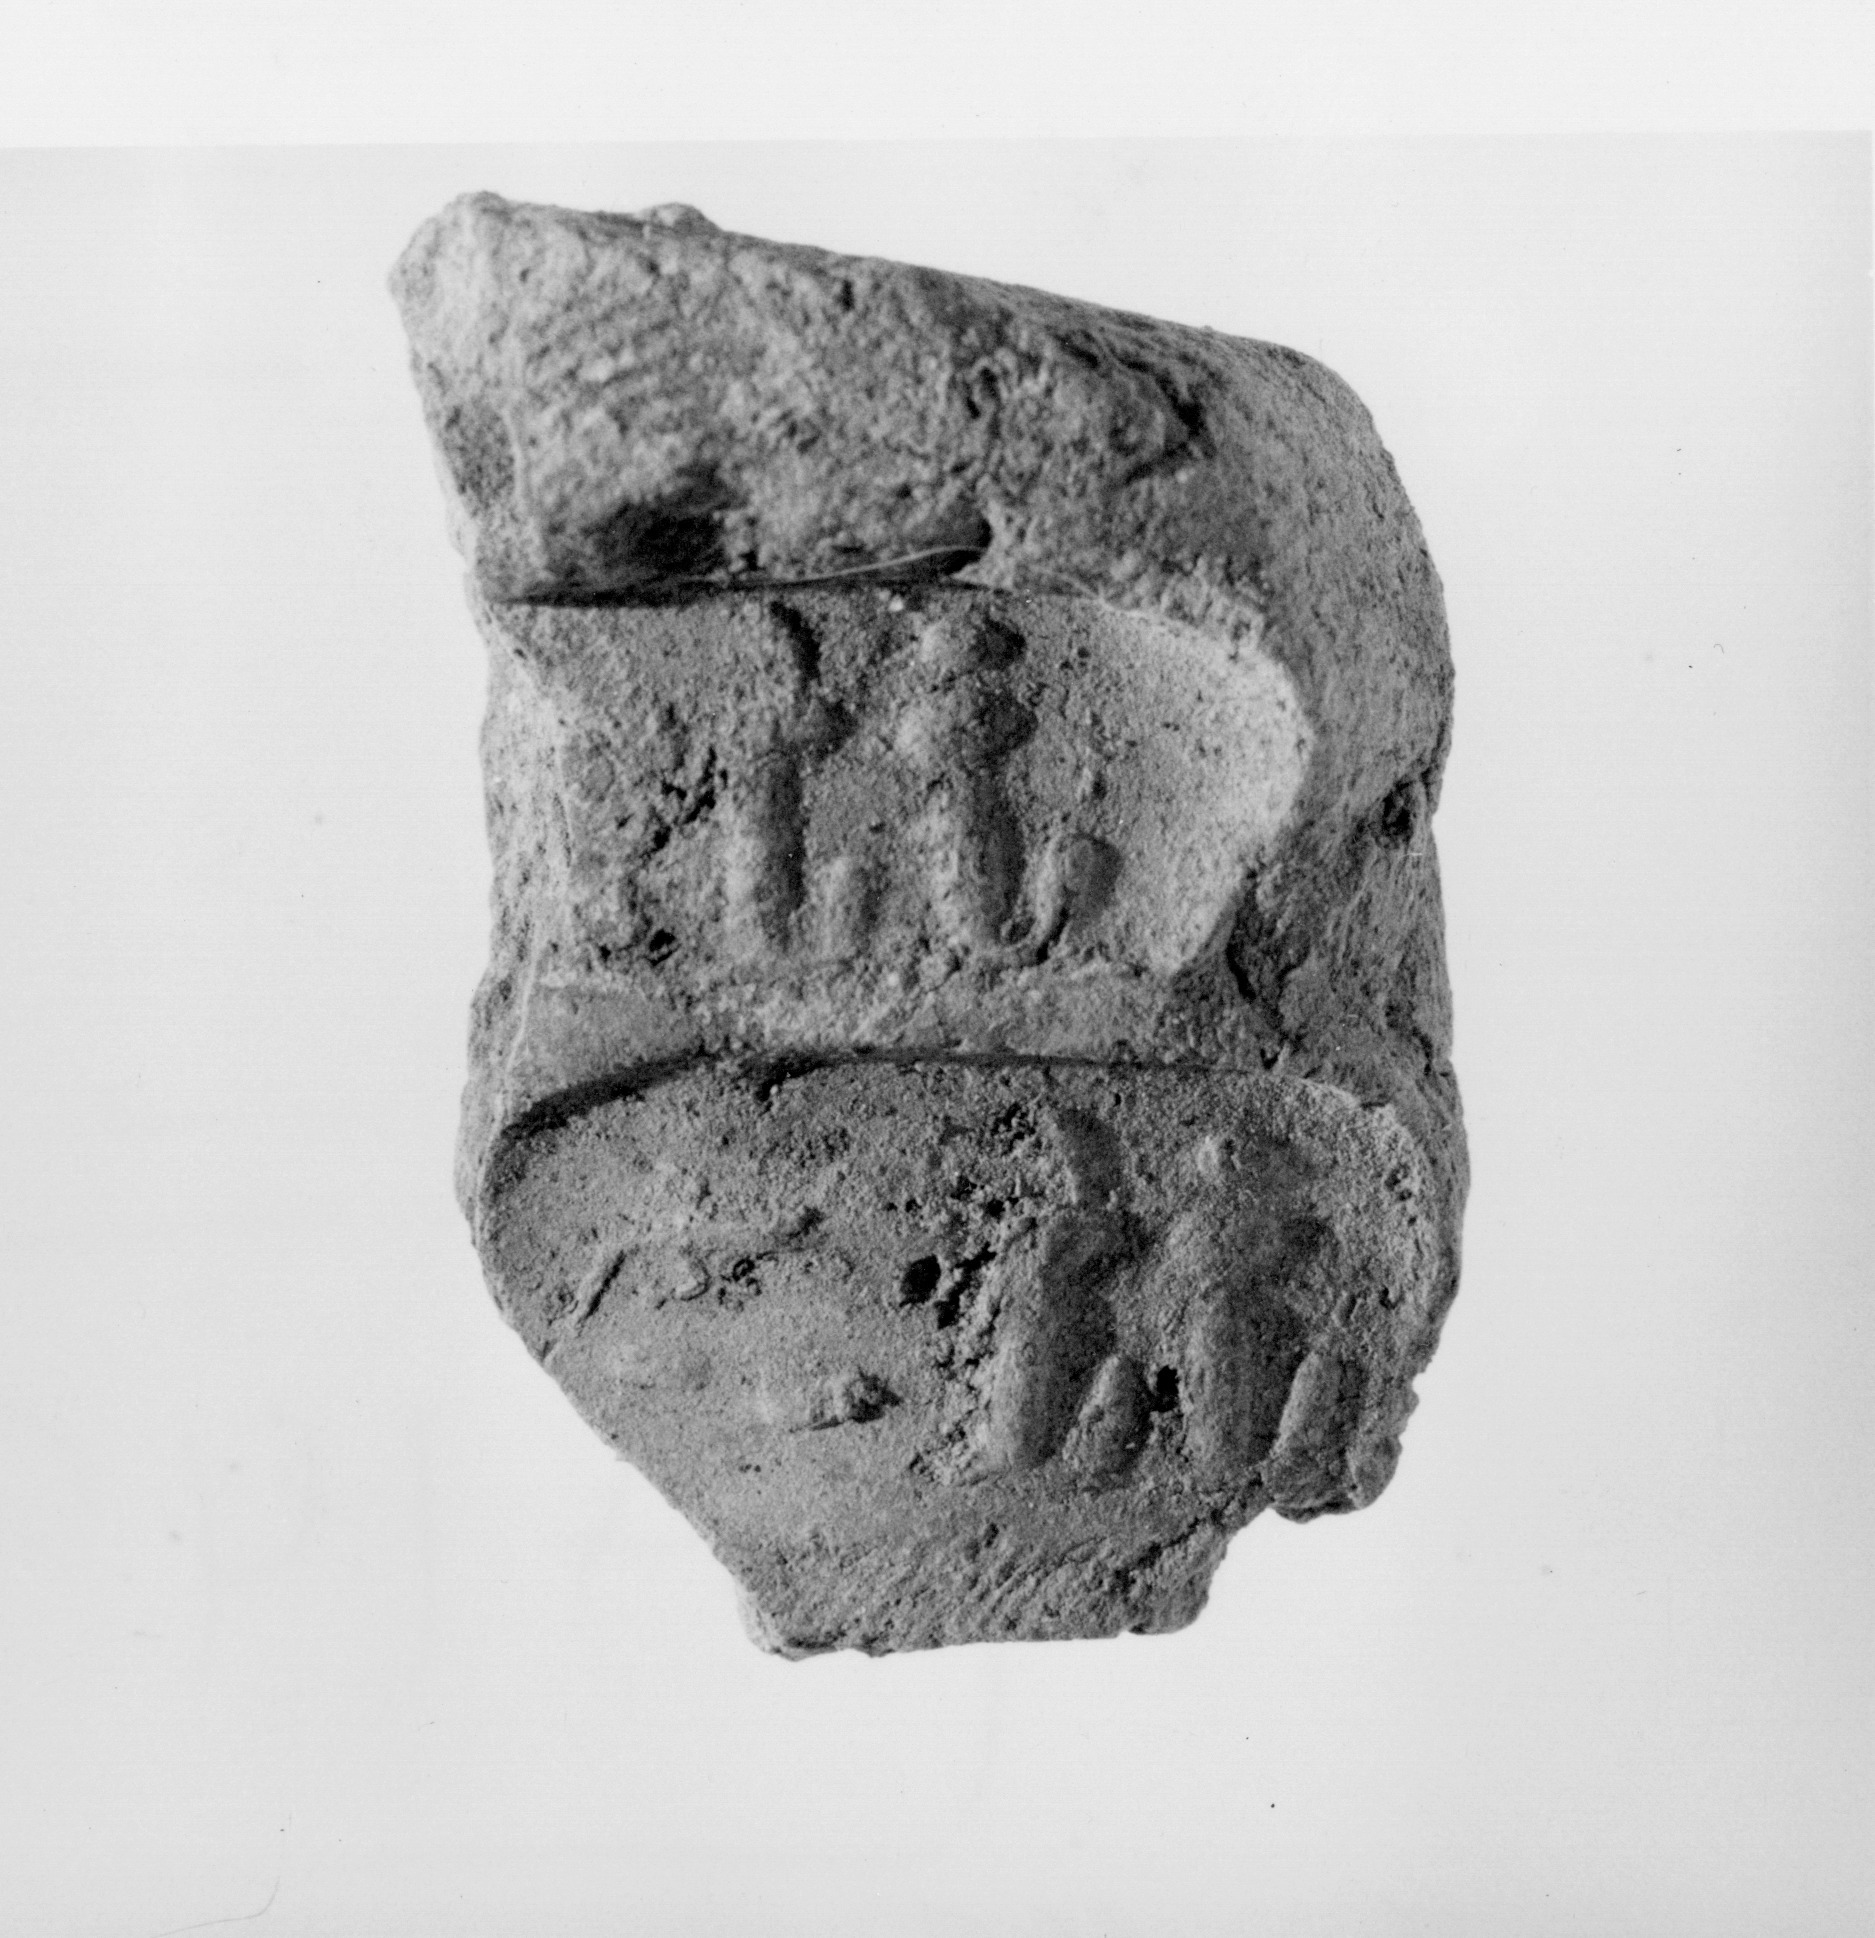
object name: sealing, nebmaatre, amenhotep iii,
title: Document Sealing With the Throne Name of Amenhotep III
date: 1390-1352 BCE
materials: mud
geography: egypt